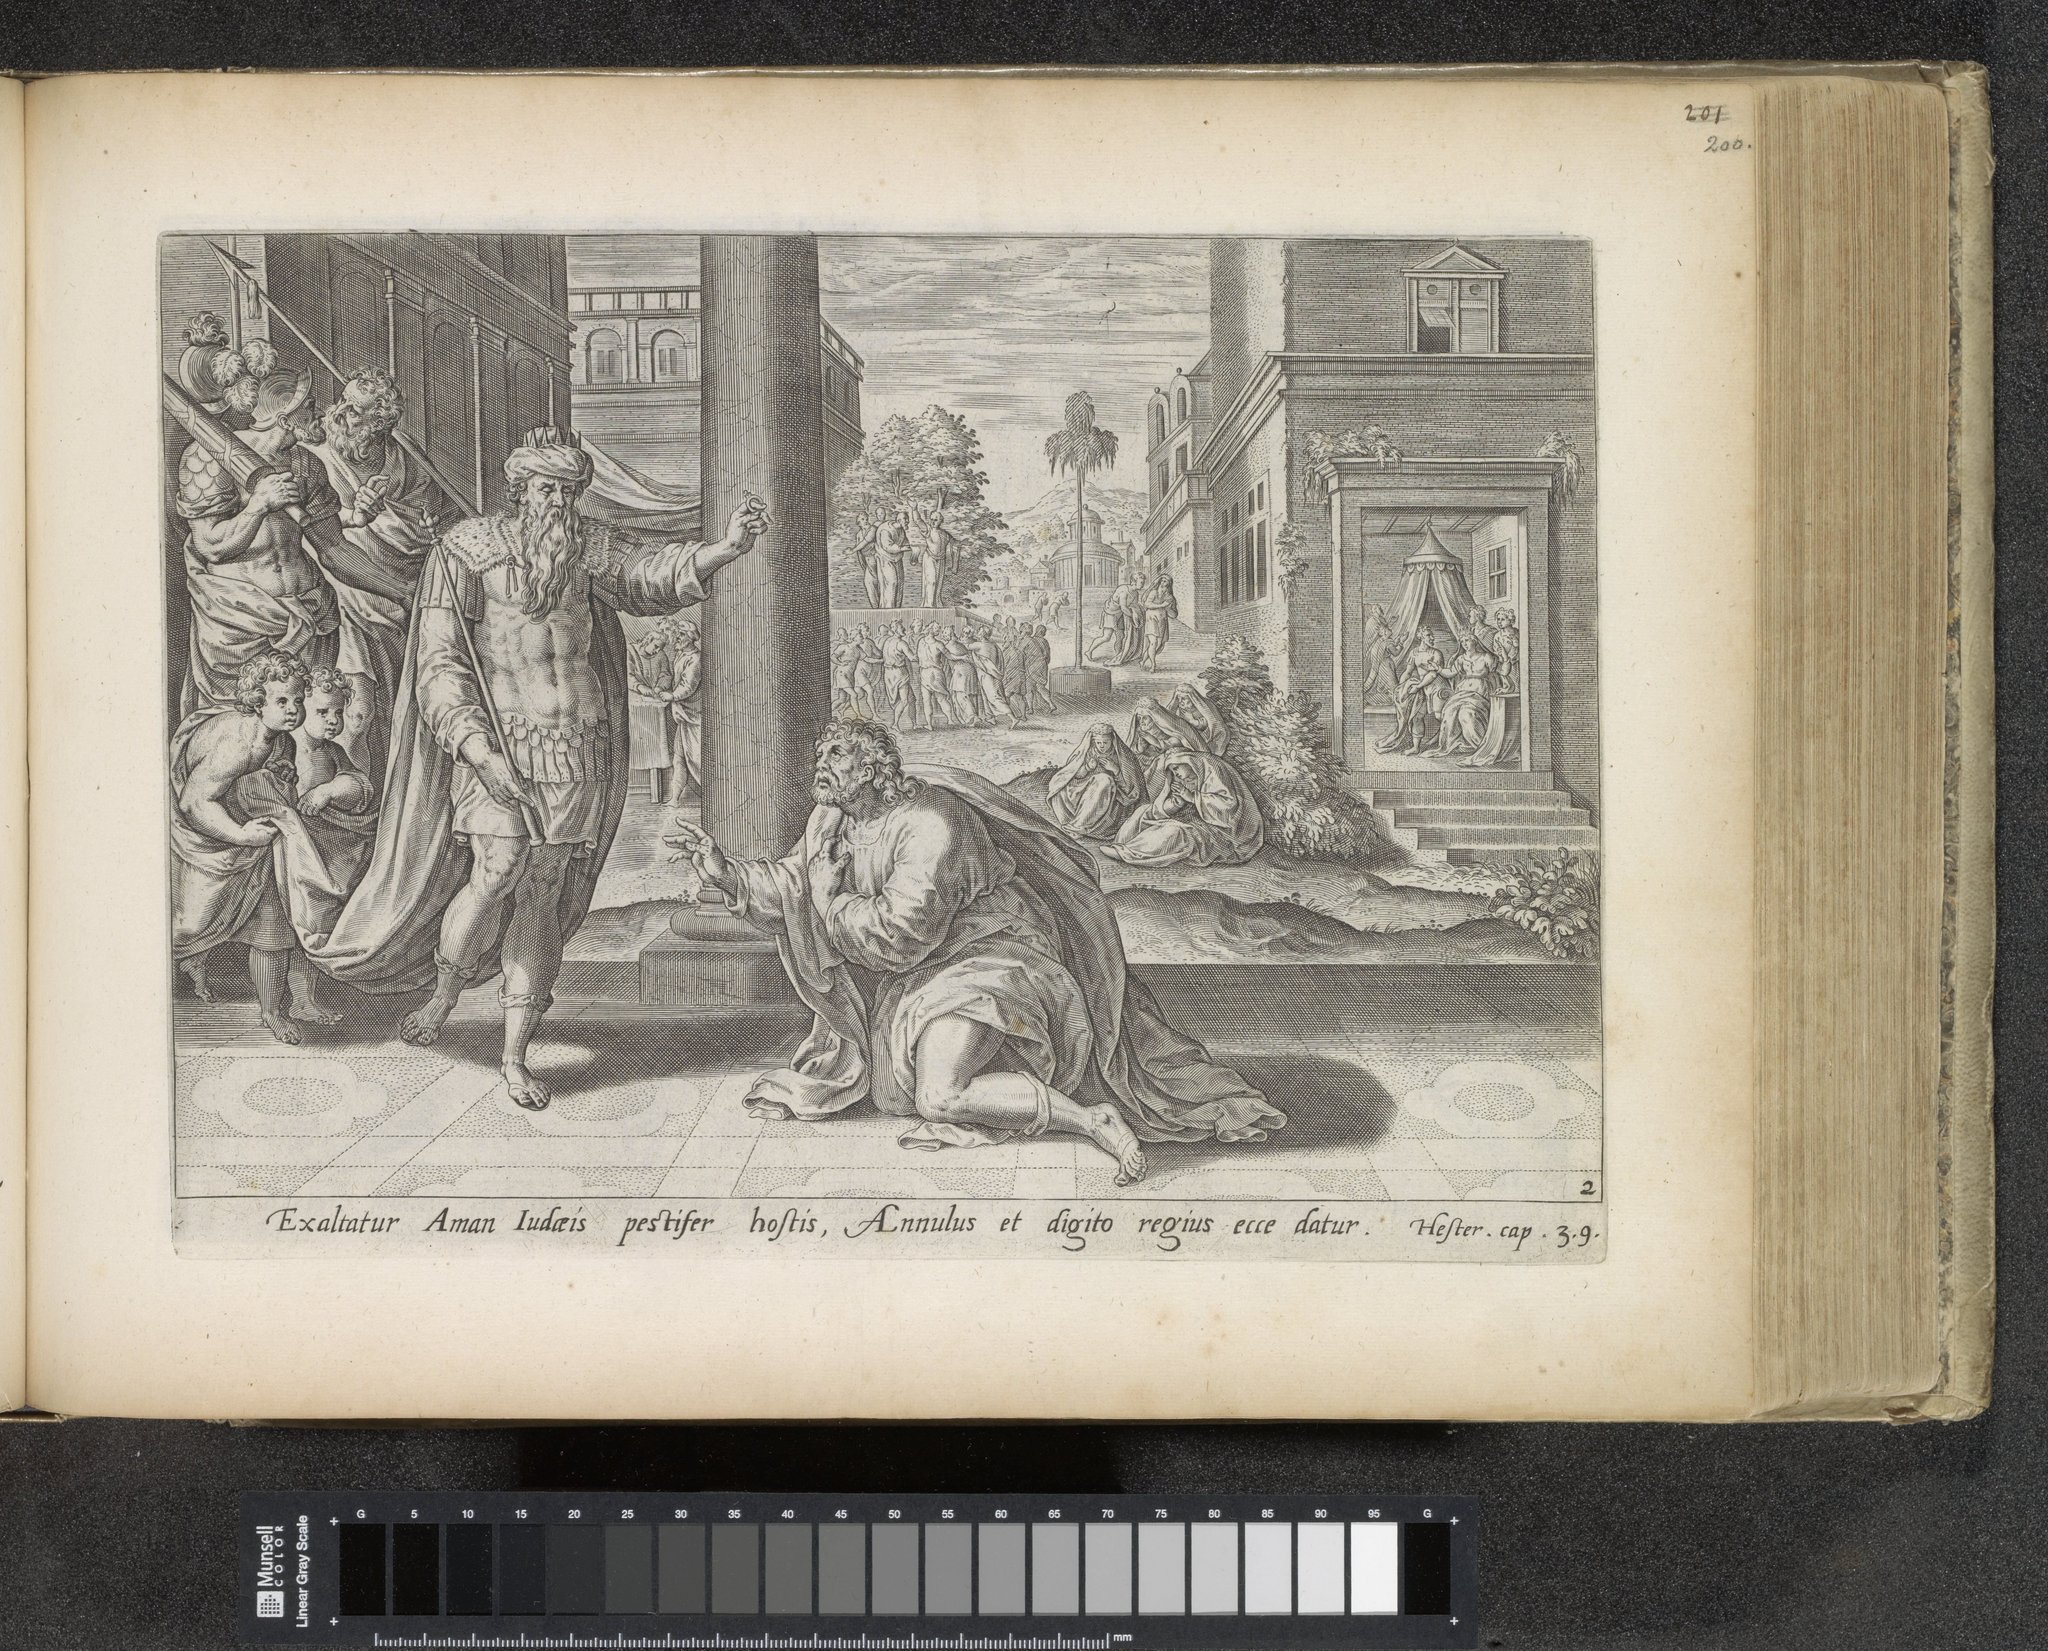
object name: print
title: Ahasveros geeft zijn ring aan Haman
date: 1579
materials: paper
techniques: engraving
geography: amsterdam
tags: mourning, prayer and distress of esther (esther 14), the jews mourn throughout the kingdom, a royal decree is issued and sent throughout the country ~ haman's plot against the jews, haman entreats ahasuerus to issue a decree that all the jews are to be put to death; ahasuerus consents and yields his signet-ring to haman, esther sends mordecai some clothes; he refuses them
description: Koning Ahasveros geeft zijn zegelring aan Haman, waarmee Haman uit naam van de koning zijn plan kan laten uitvoeren om alle Joden ter dood te laten brengen. Op de achtergrond wordt het besluit verkondigd. Een groepje Joden zit te treuren met as op het hoofd. Rechts koningin Ester in haar vertrek waar ze een dienaar de opdracht geeft om Mordechai kleren te brengen zodat hij die kan dragen in plaats van zijn rouwkleed. Links naast het gebouw weigert Mordechai de kleren te aanvaarden. Nog verder op de achtergrond bidt Ester om een goede afloop. Onder de voorstelling een verwijzing in het Latijn naar de Bijbeltekst in Est. 3:9. Deze prent maakt deel uit van een album.